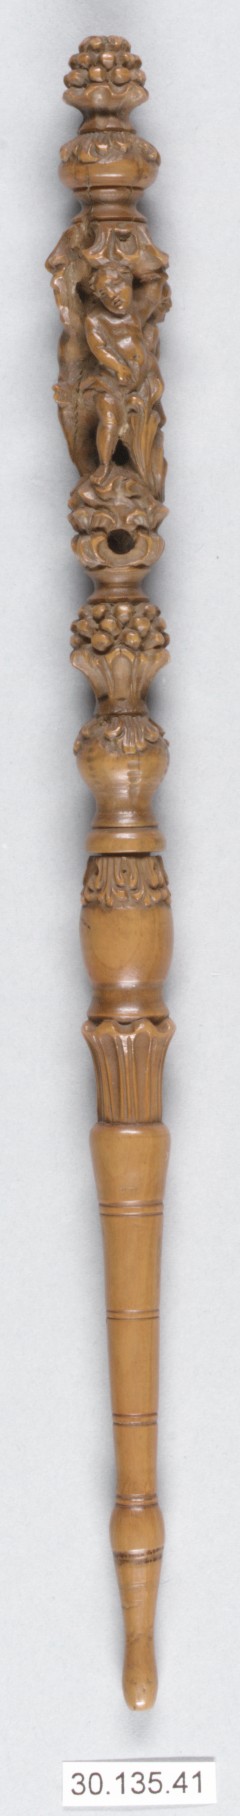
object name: needle sheath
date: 1601-1733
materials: wood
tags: putti